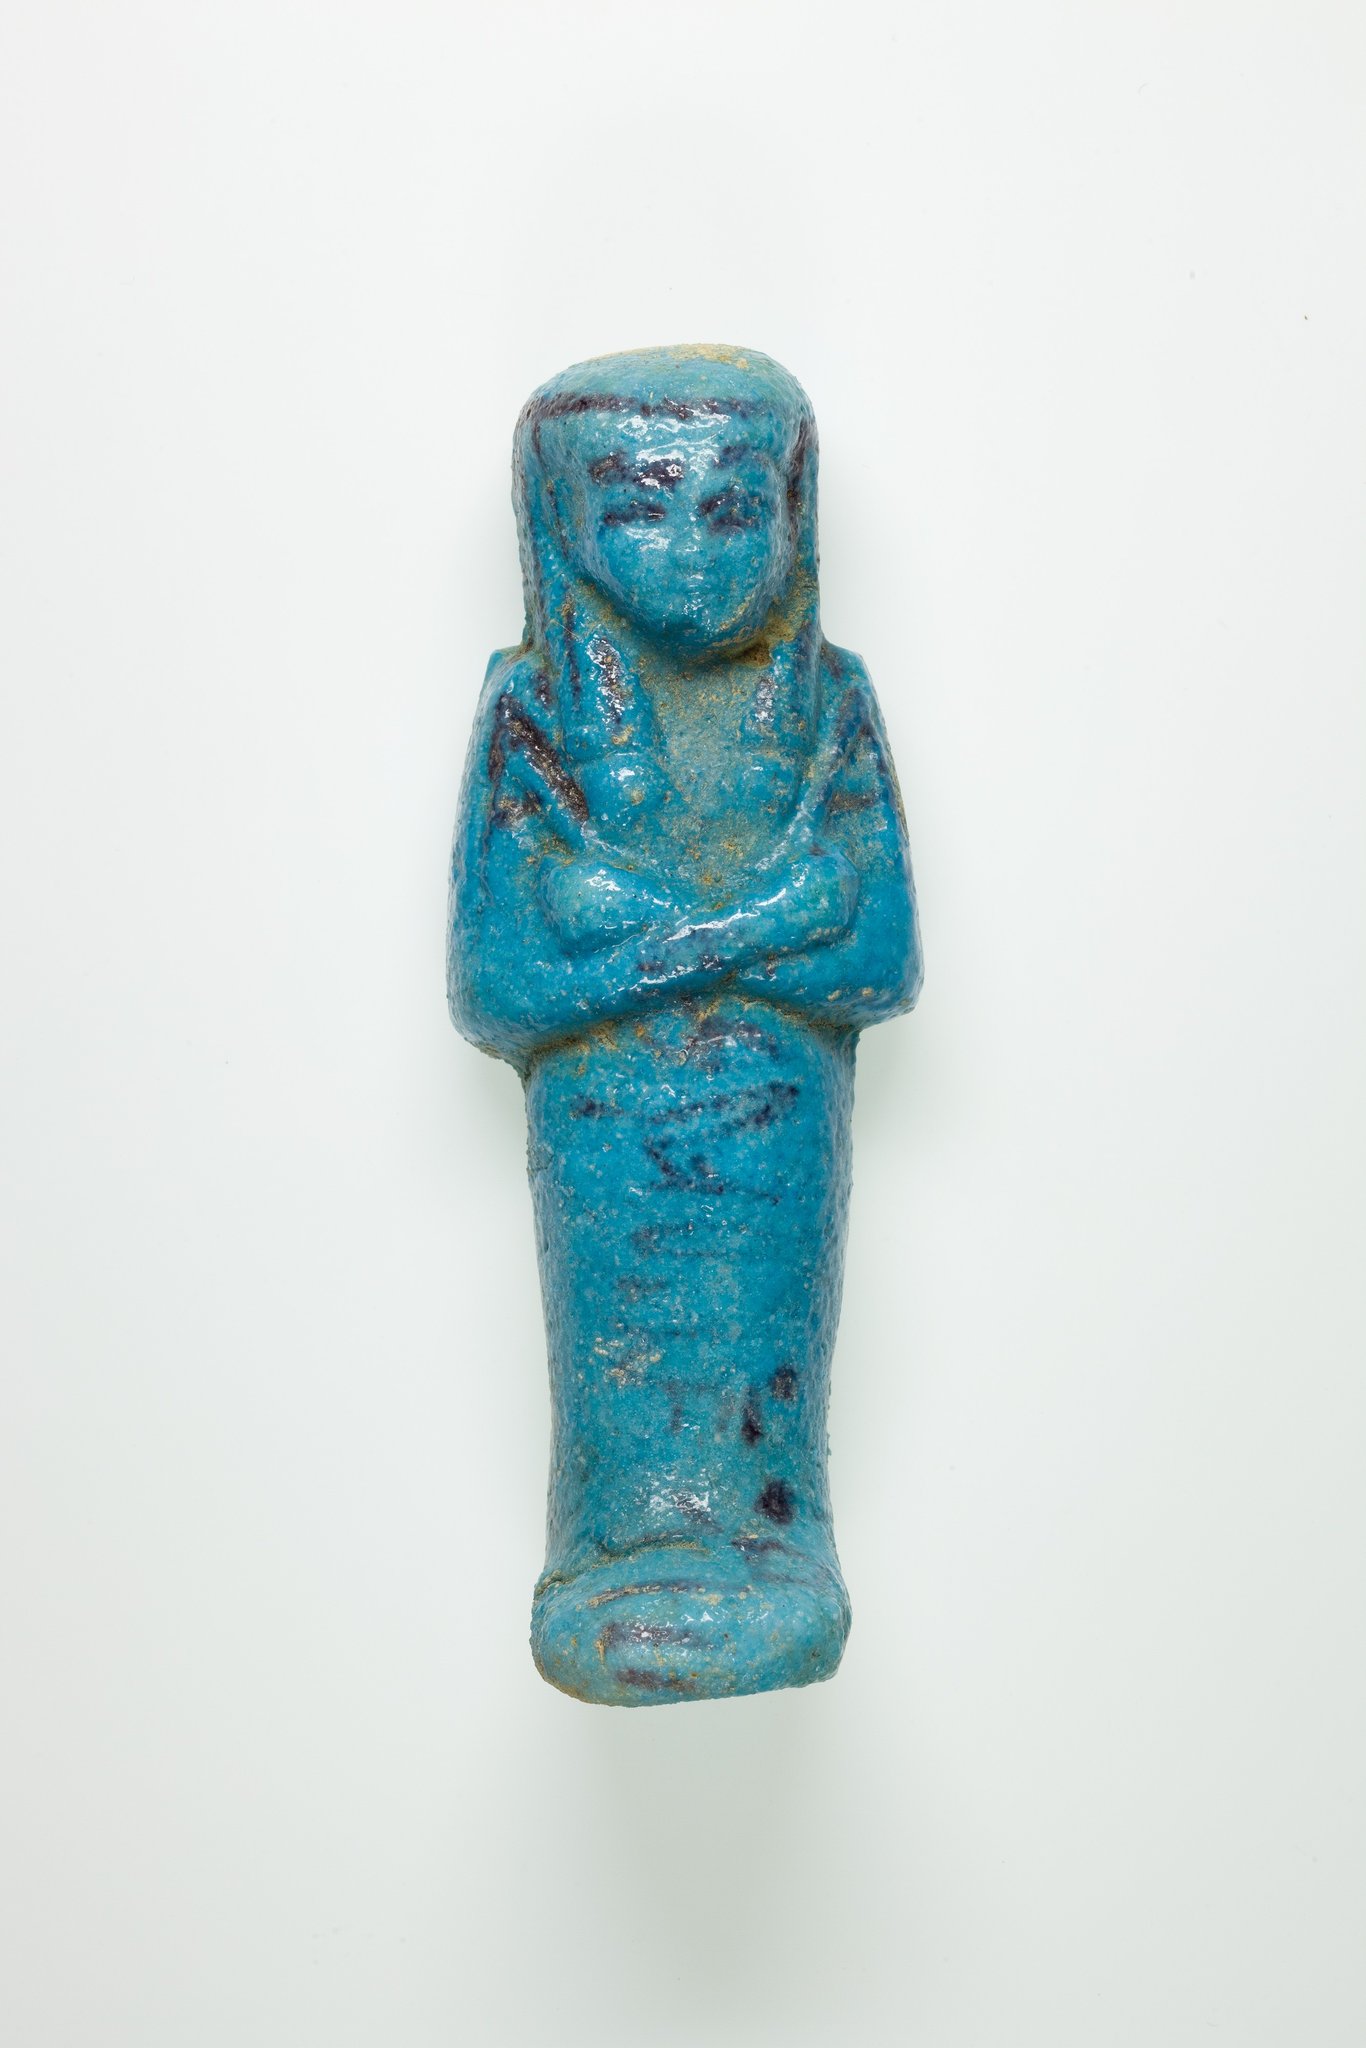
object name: worker shabti, henettawy c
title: Worker Shabti of Henettawy (C), Daughter of Isetemkheb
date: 990-970 BCE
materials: faience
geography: egypt